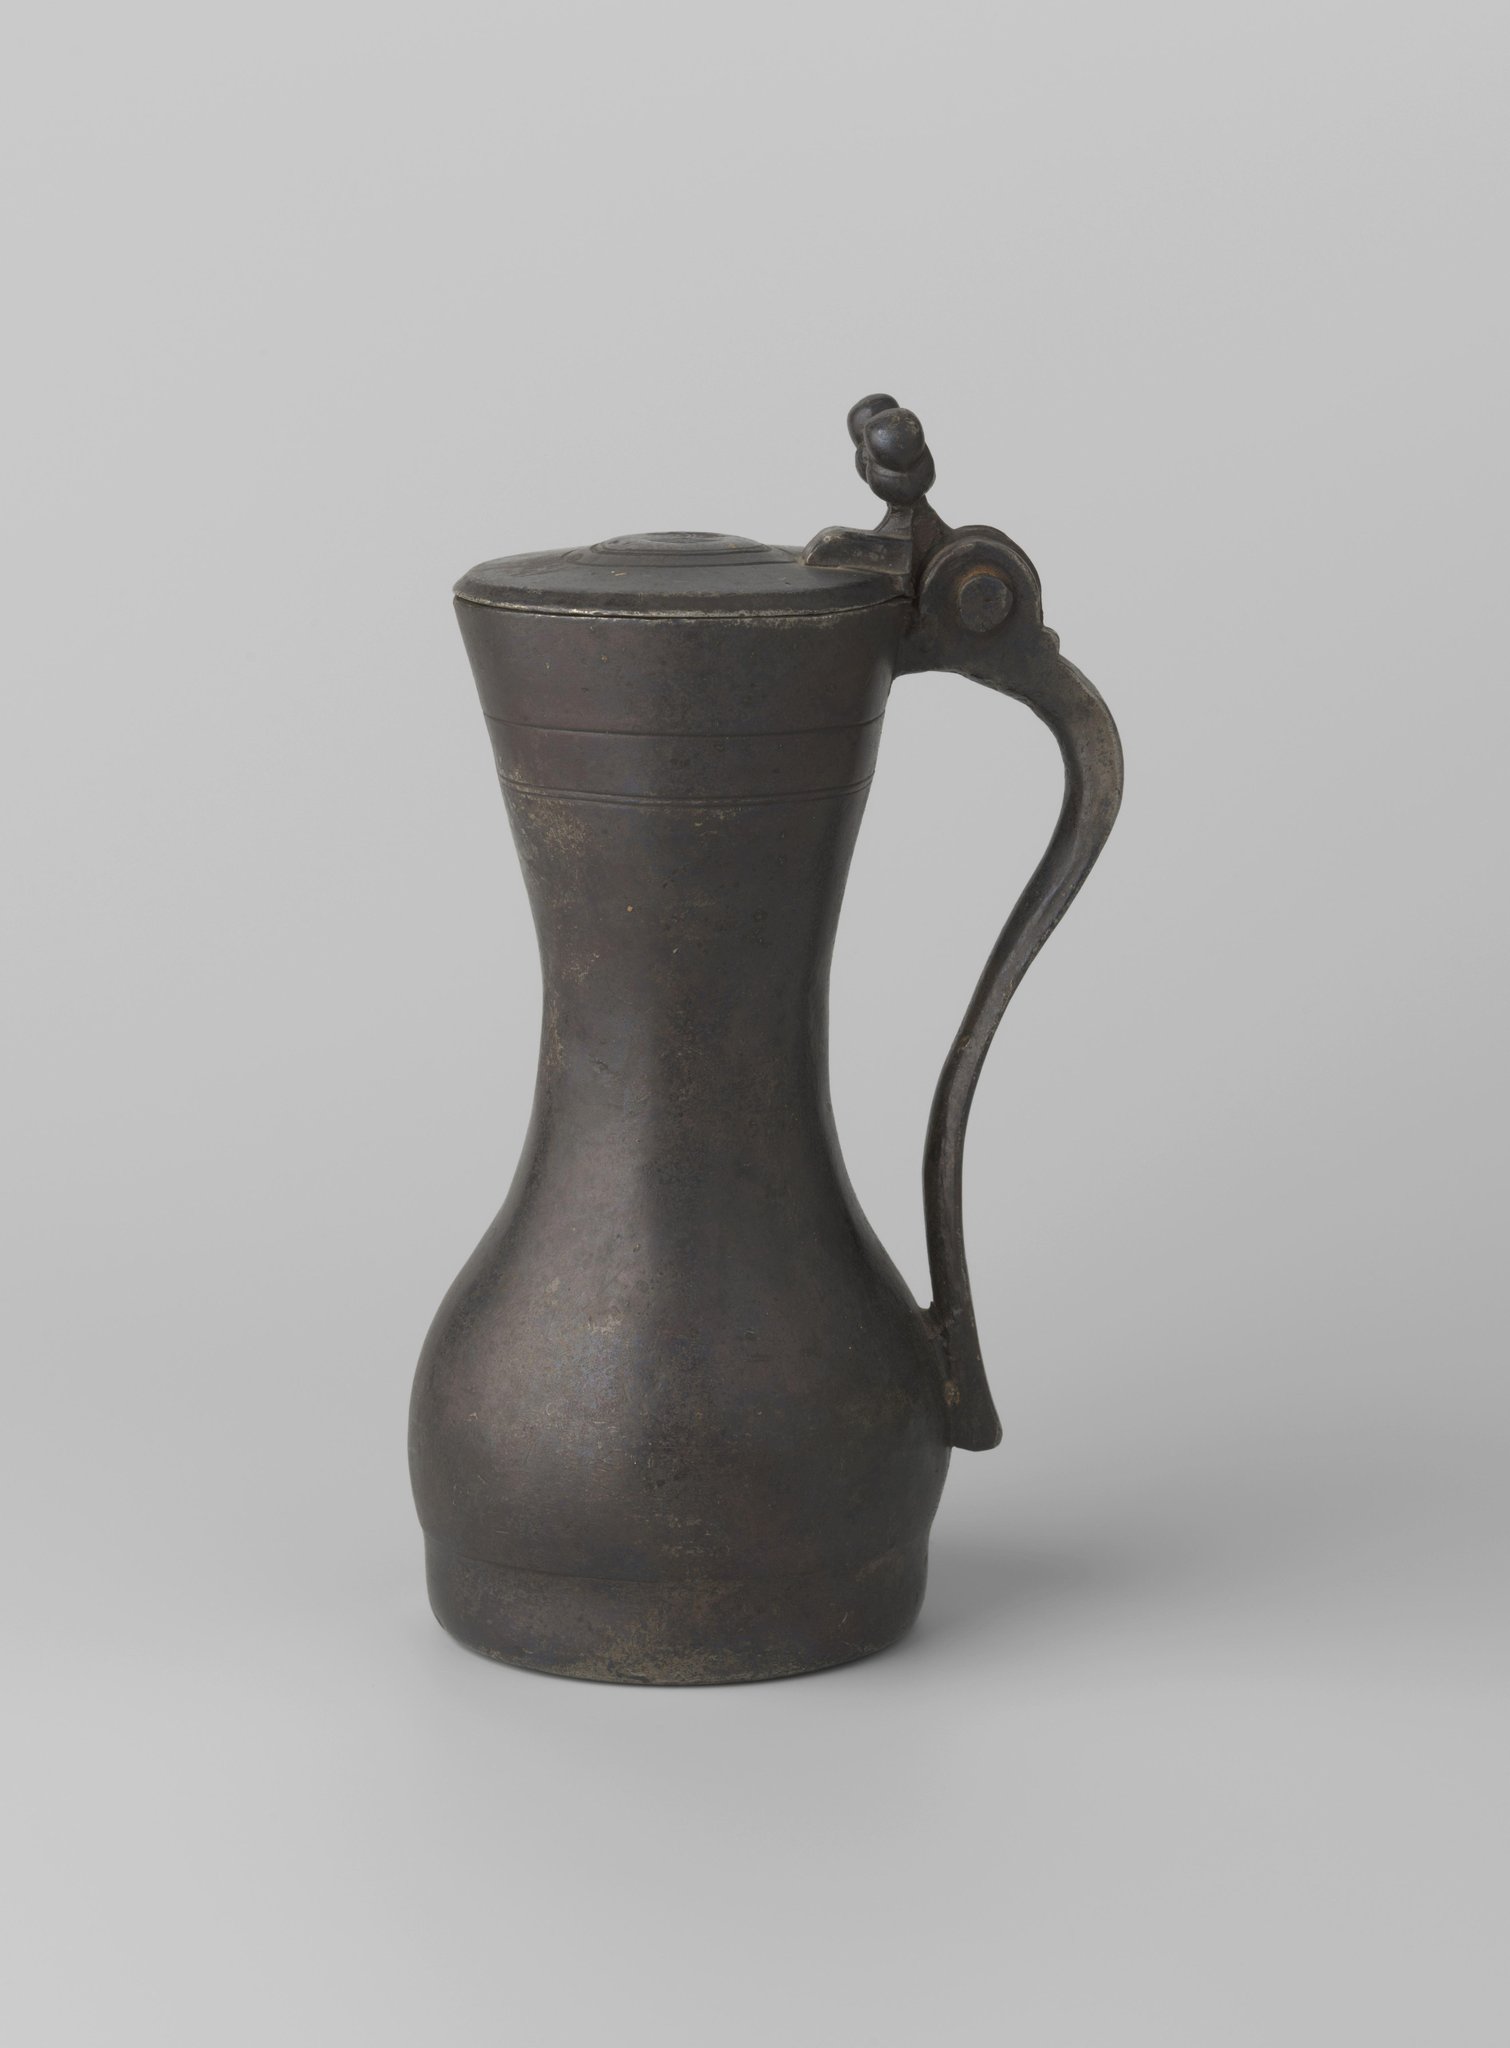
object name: jug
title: Tinnen kruik met deksel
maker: Anonymous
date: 1475-1525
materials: tin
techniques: casting, turning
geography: amsterdam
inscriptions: maker's mark, quality mark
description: Kan van tin. De laagzittende buik gaat in het midden over in de nauwere hals, die zich naar binnen toe geleidelijk verbreedt en wordt afgesloten door een geprofileerd deksel. Zij heeft een éénkakig scharnier en twee eikels als klauwstuk. De kan is boven en onderaan met profiellijnen versierd. Op de bodem een niet te ontcijferen medaillon. Gemerkt op het deksel met het wapen van Amsterdam, waarop de keizerskroon en een meesterteken: een ruit met o.a. een gothische F. De kan is van tin met een donker patina en luster.